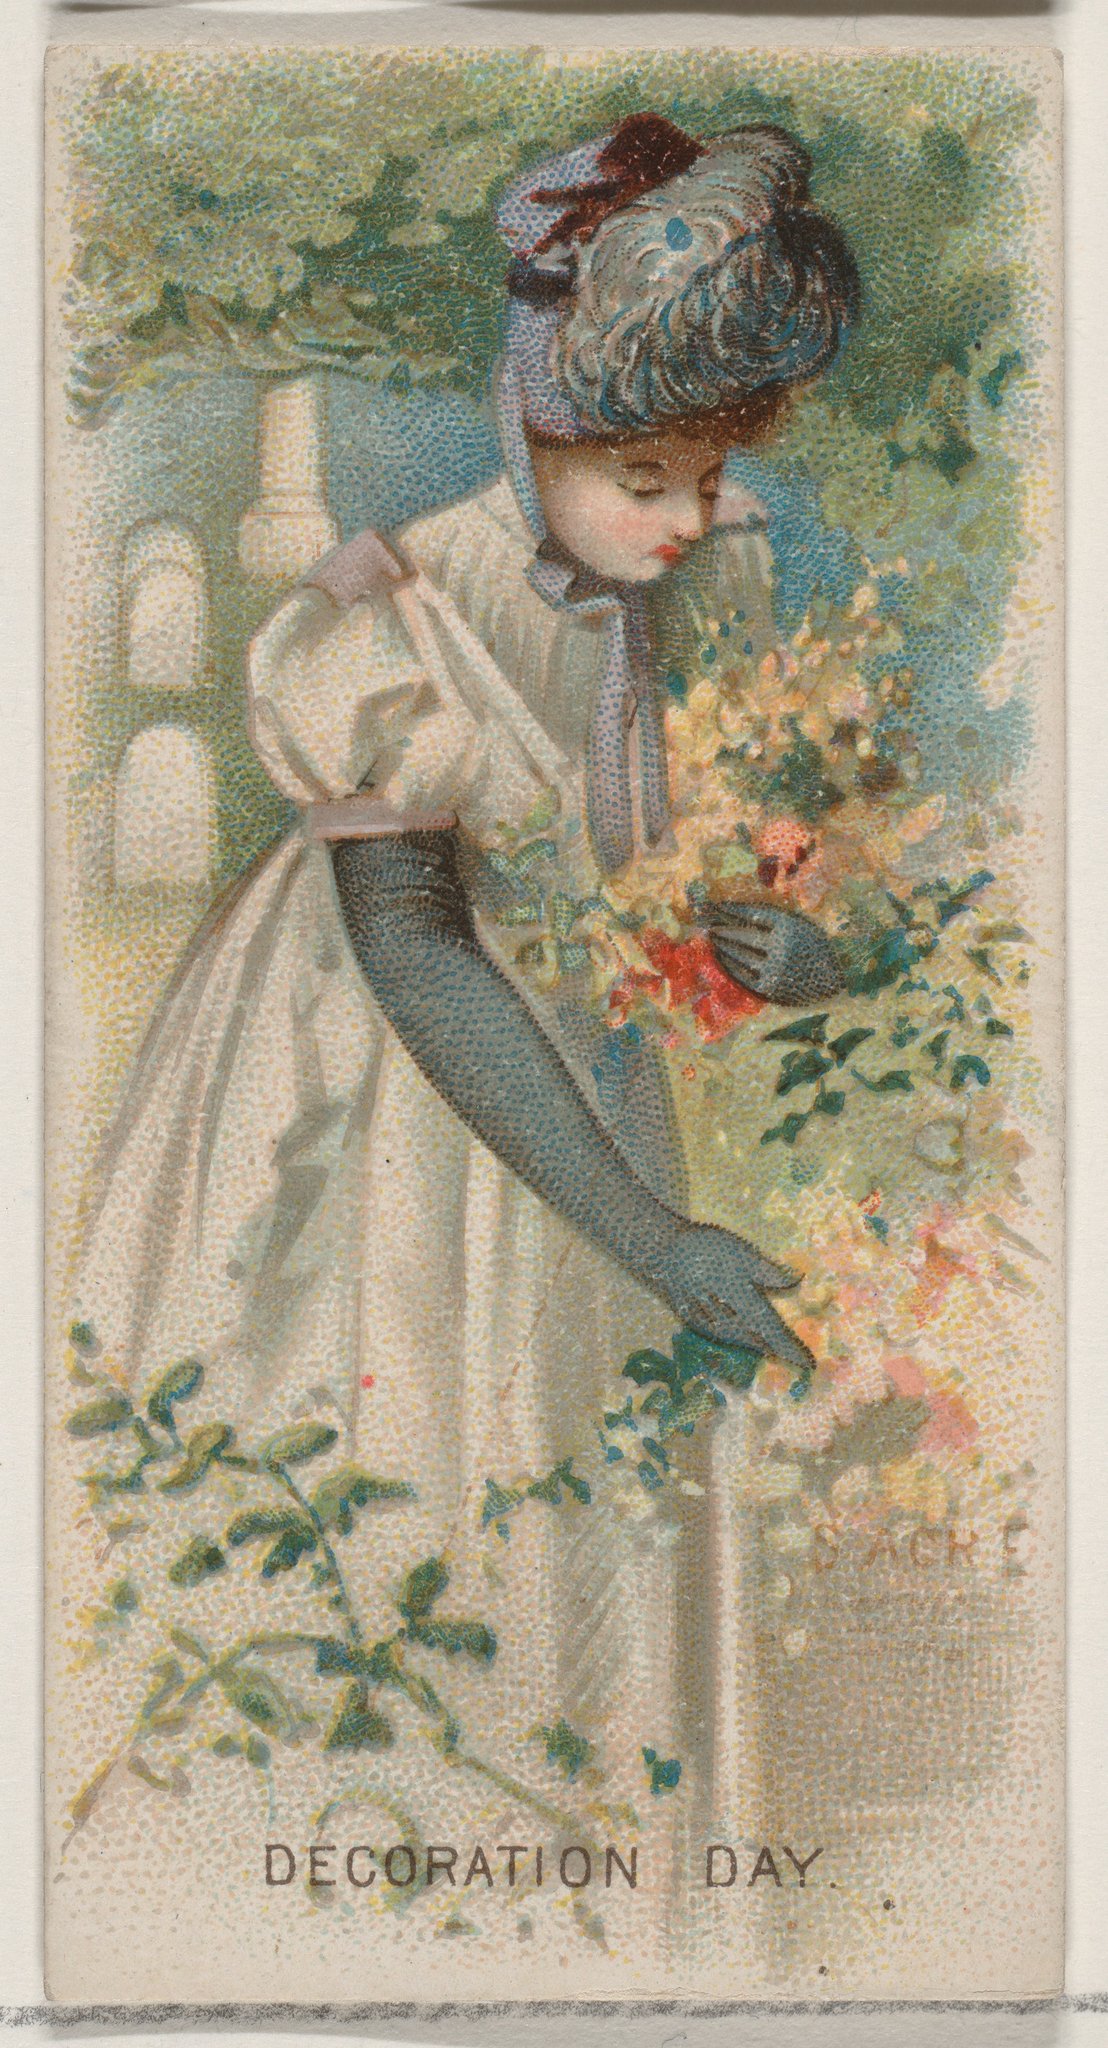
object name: print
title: Decoration Day, United States, from the Holidays series (N80) for Duke brand cigarettes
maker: w. duke, sons & co.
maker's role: publisher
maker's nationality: american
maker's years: 1870-1920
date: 1890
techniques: color lithograph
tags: women